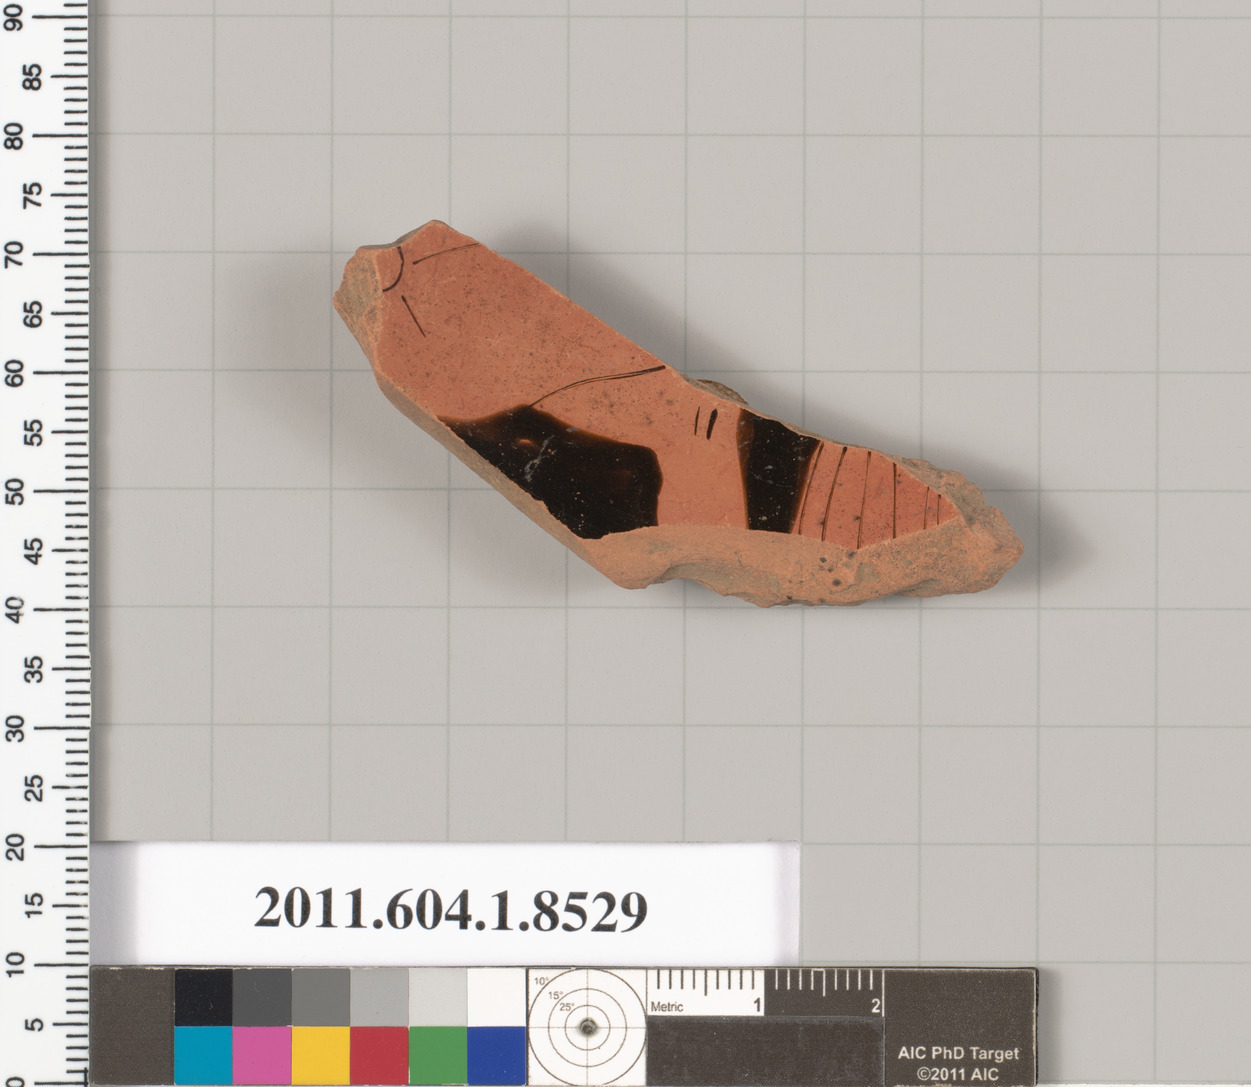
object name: kylix fragment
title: Terracotta fragment of a stemless kylix (drinking cup)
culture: greek, attic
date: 467-435 BCE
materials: terracotta